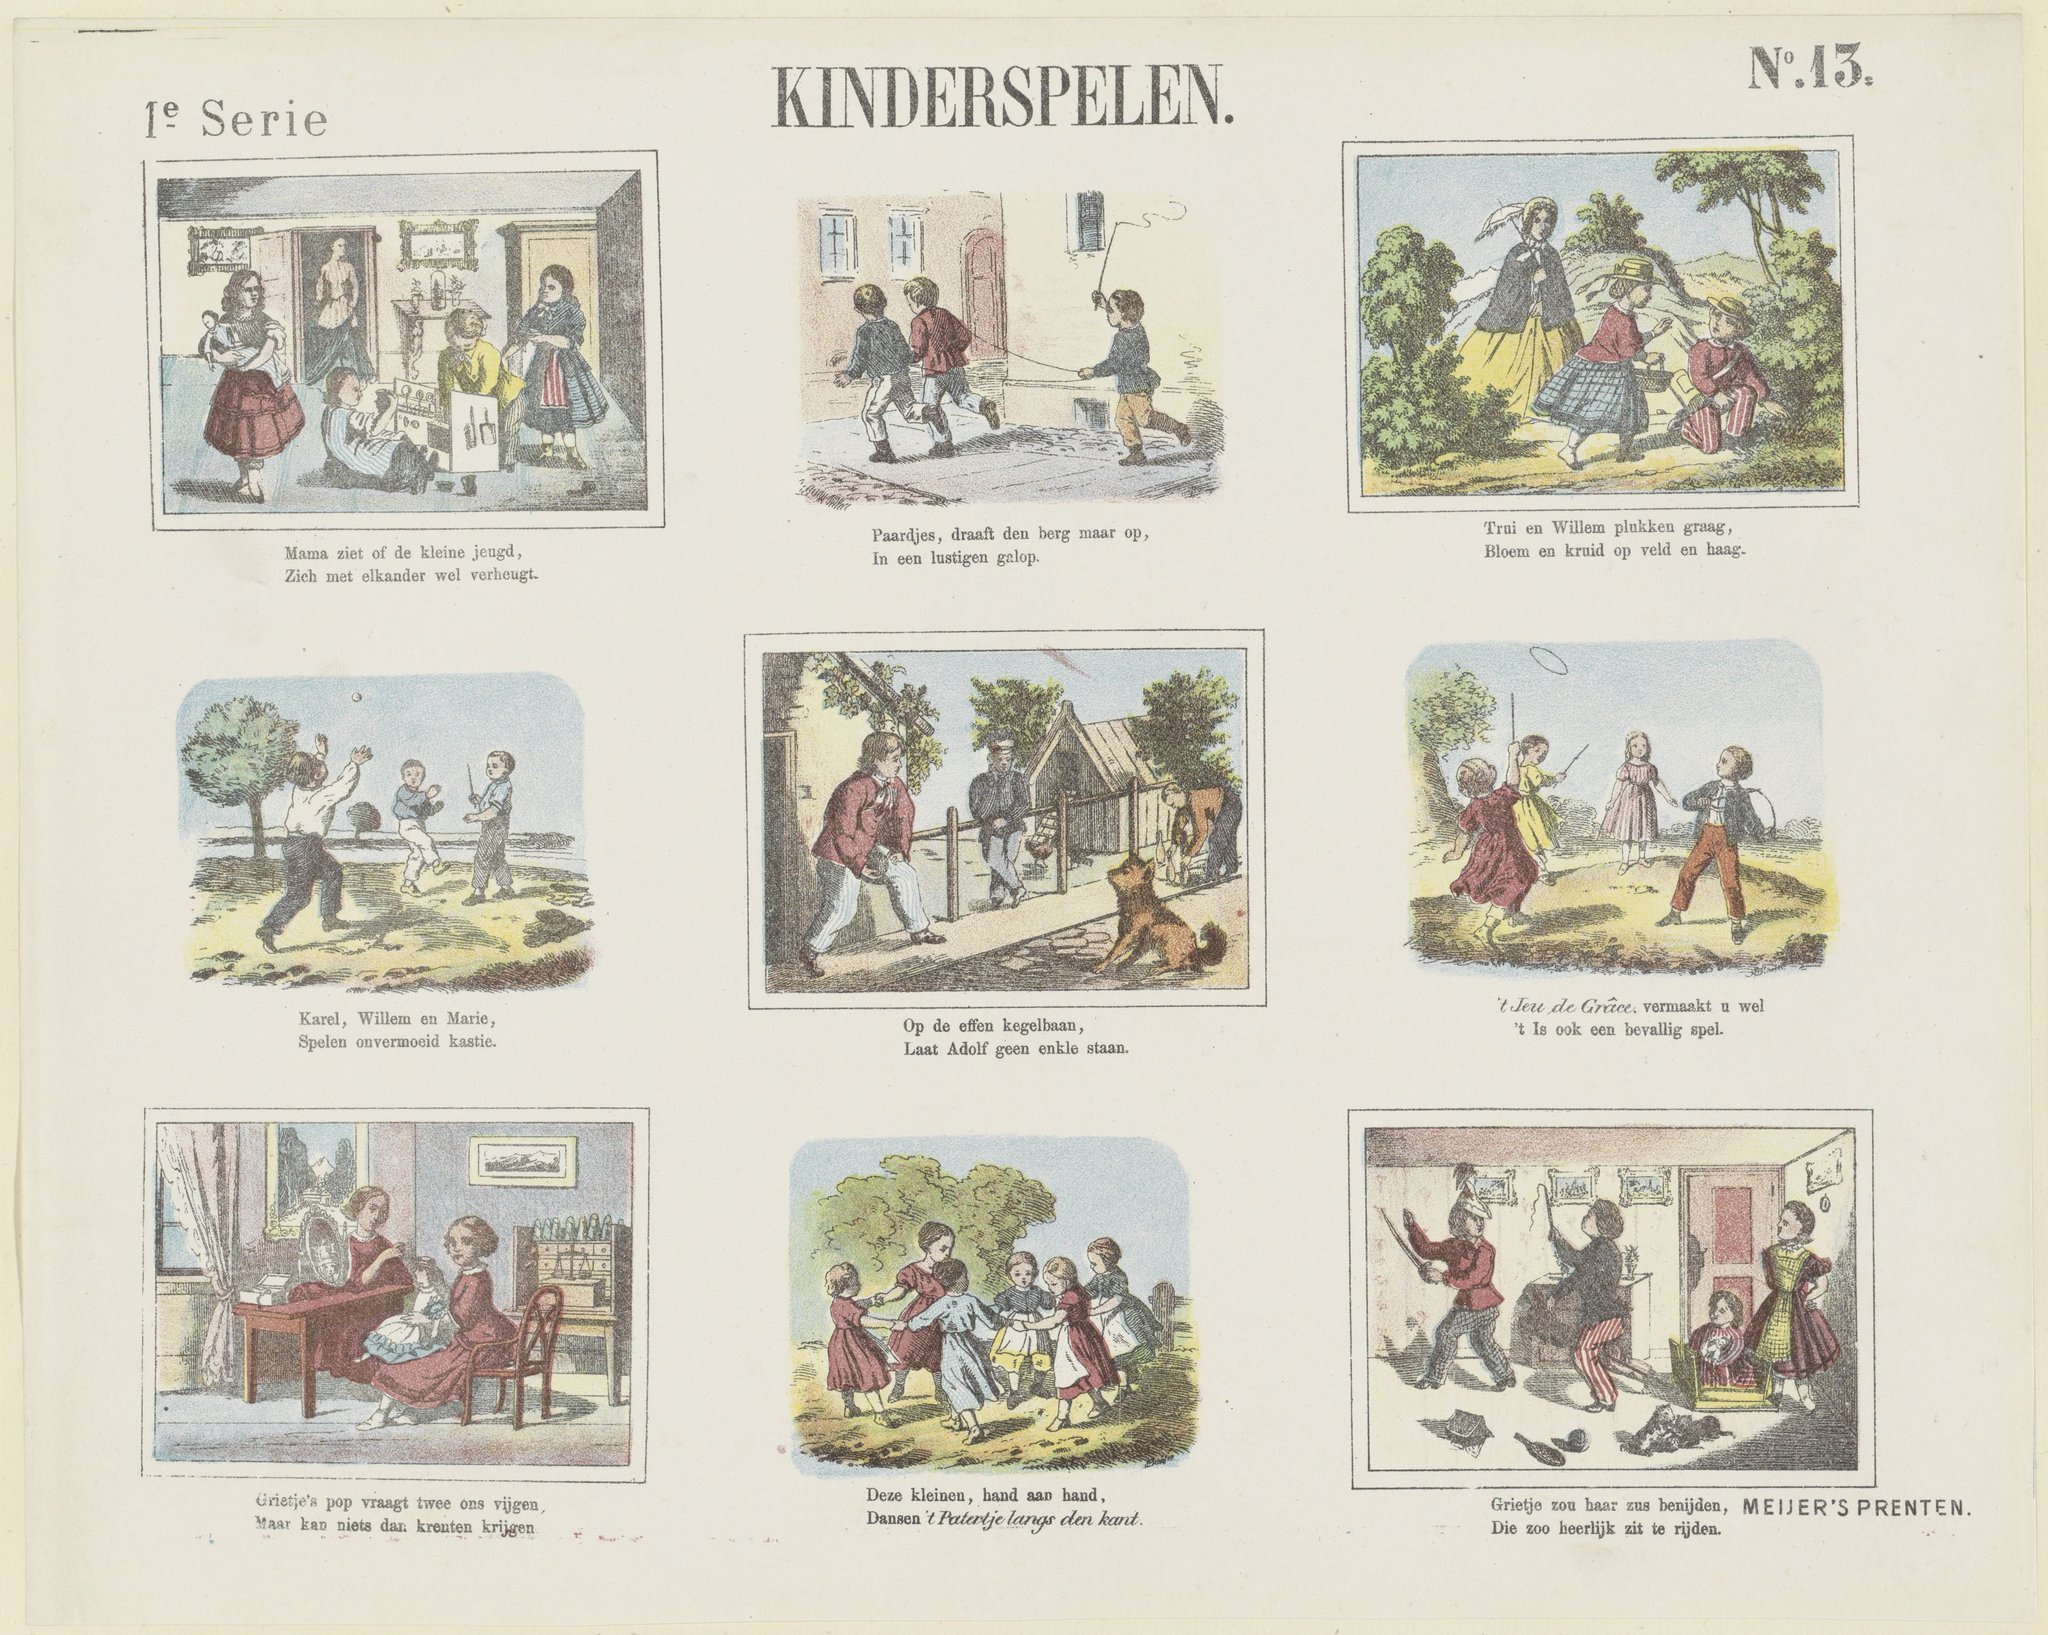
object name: popular print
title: Kinderspelen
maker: Anonymous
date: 1873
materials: paper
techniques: lithograph, letterpress printing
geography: amsterdam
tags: children's games and plays, dancing, (playing with) dolls, games using special objects (marbles, top, hoop, etc.)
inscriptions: collector's mark: Lugt 2760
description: Blad met 9 voorstellingen van kinderspelen, waaronder winkeltje spelen, paardje spelen, bloemen plukken, ballen, kegelen, hoepel vangen, met de pop spelen, rondedans en soldaatje spelen. Onder elke afbeelding een tweeregelig vers. Genummerd rechtsboven: No. 13.